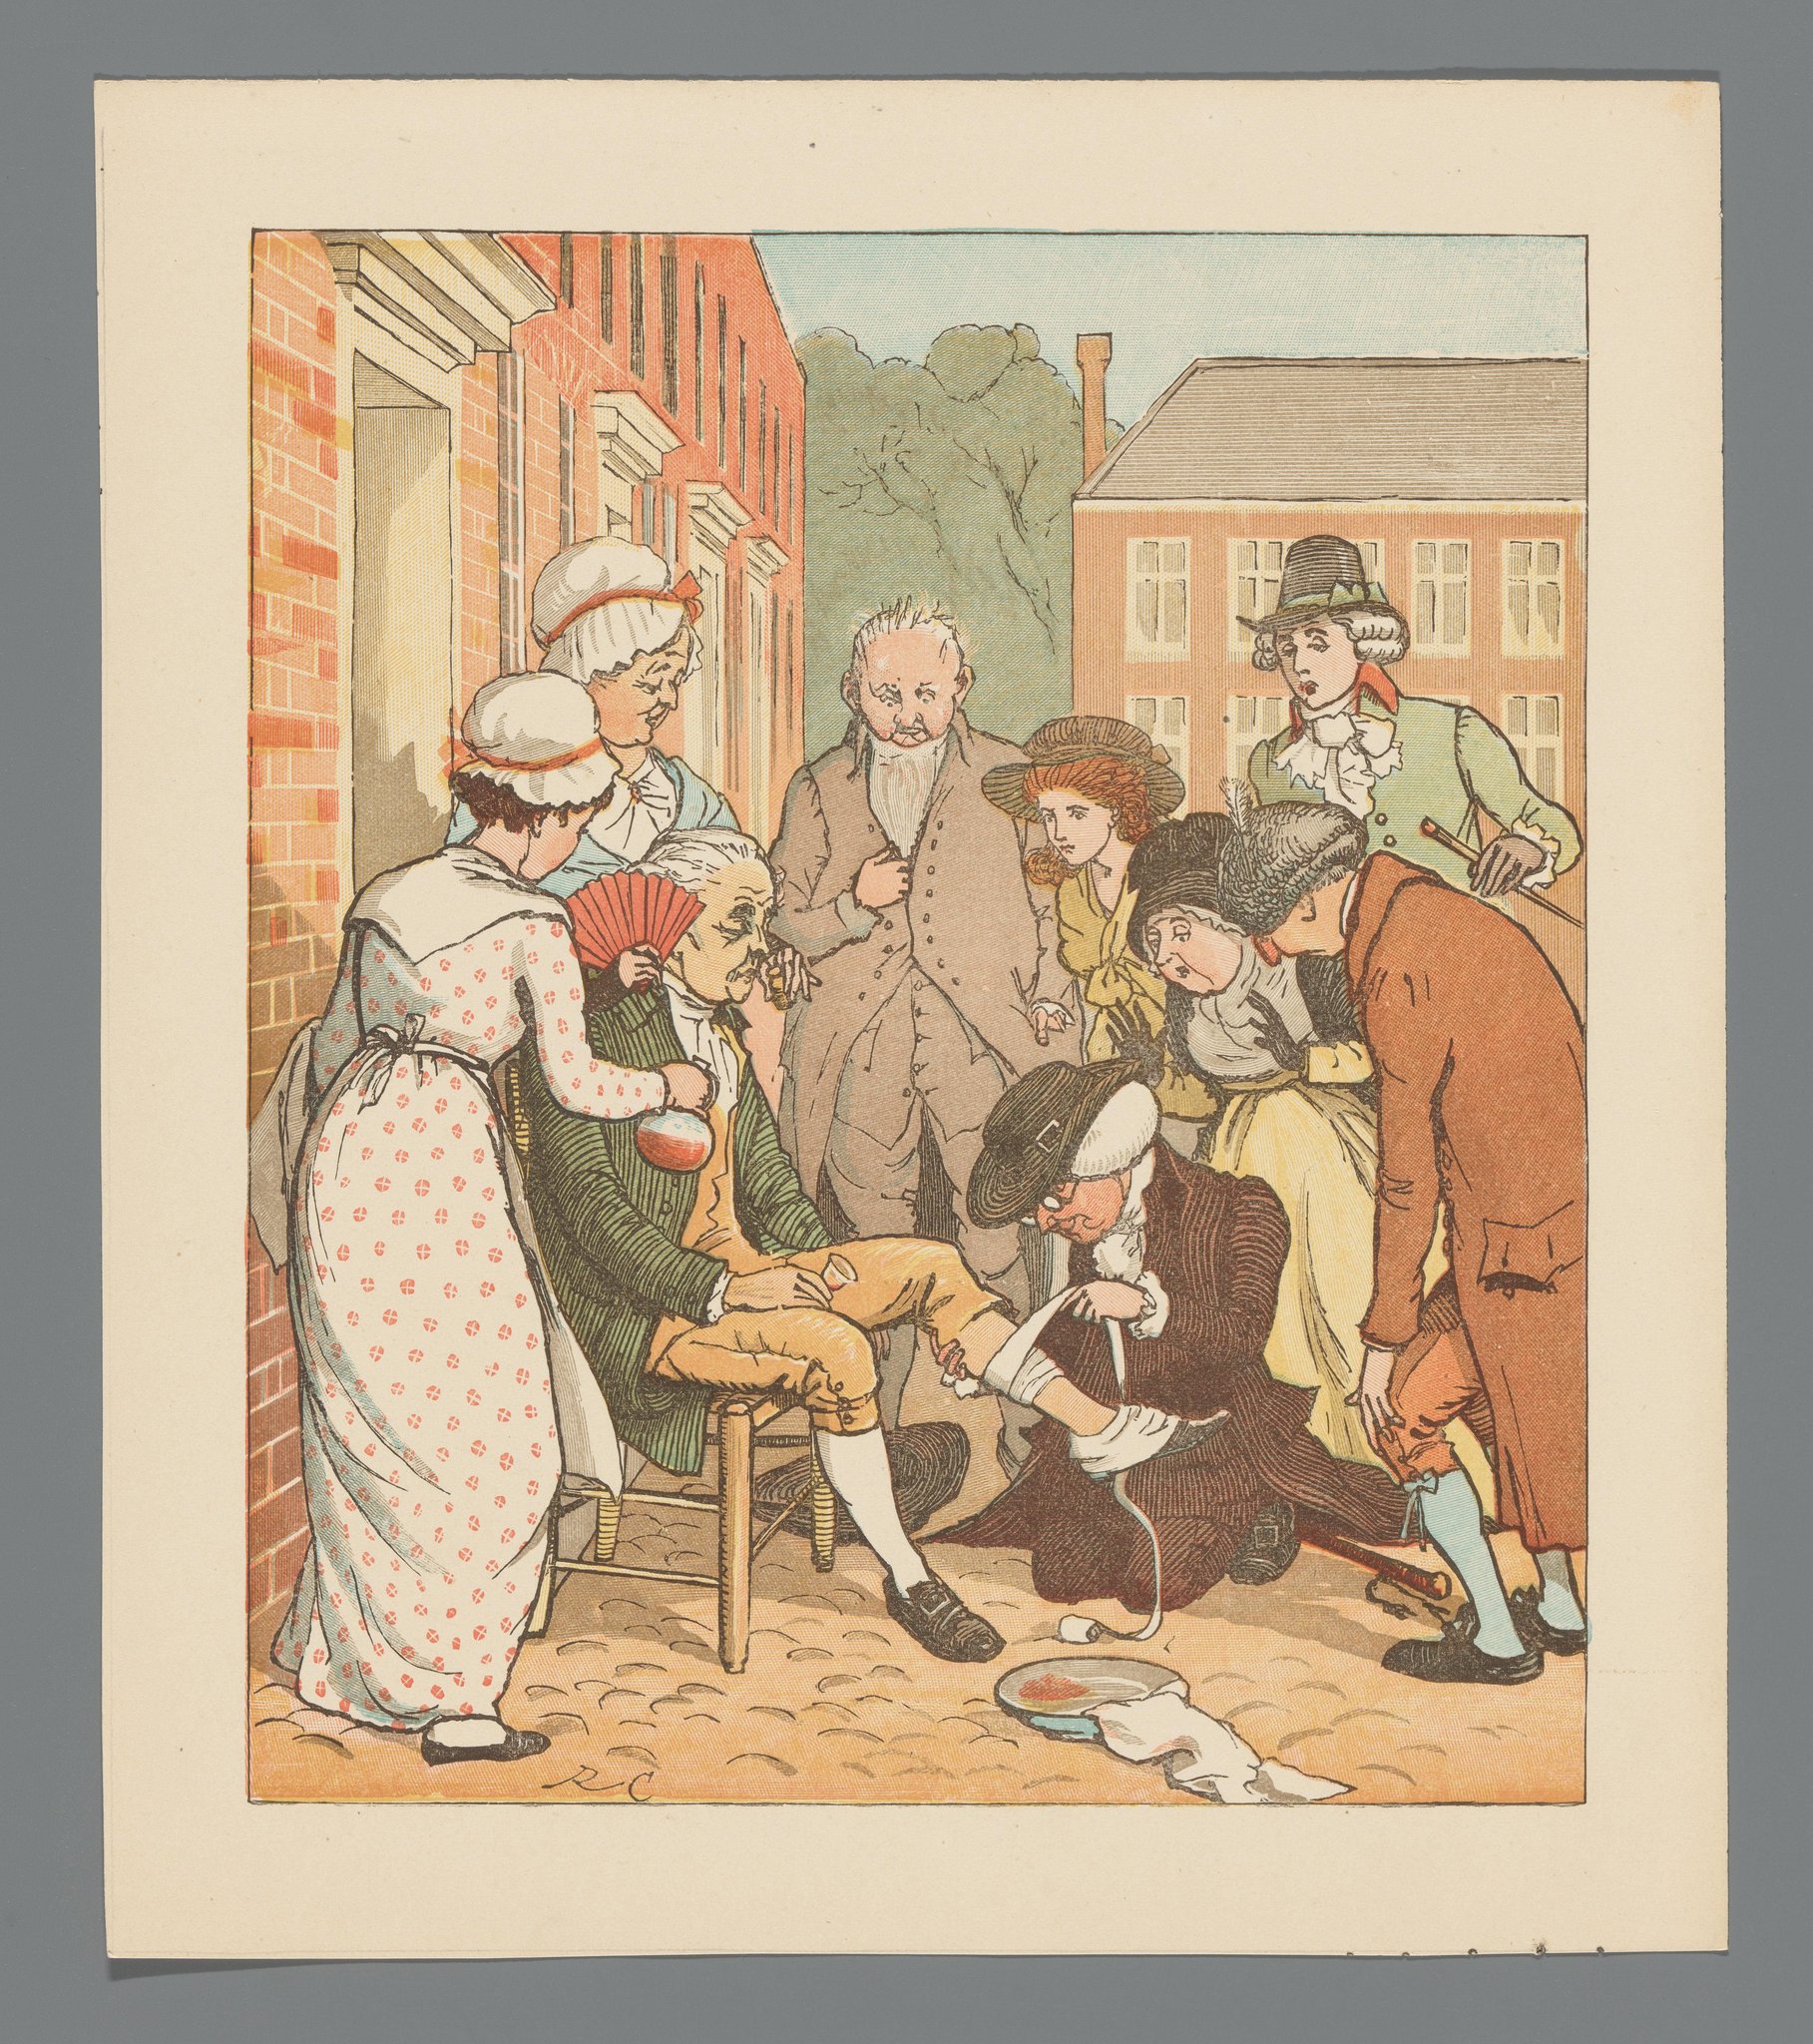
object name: print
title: Man zwachtelt het been van een gewonde man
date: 1879-1927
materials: paper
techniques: wood engraving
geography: london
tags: applying dressing or bandage, the (nude) human figure; 'corpo humano' (ripa) (+ more than eight persons), infections and wounds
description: Prent uit: Goldsmith, Oliver. Elegy on a mad dog. Londen: George Routledge & Sons, 1879. Of uit een later gepubliceerde uitgave waarin vier verhalen (waaronder 'Elegy on a mad dog') zijn gebundeld.